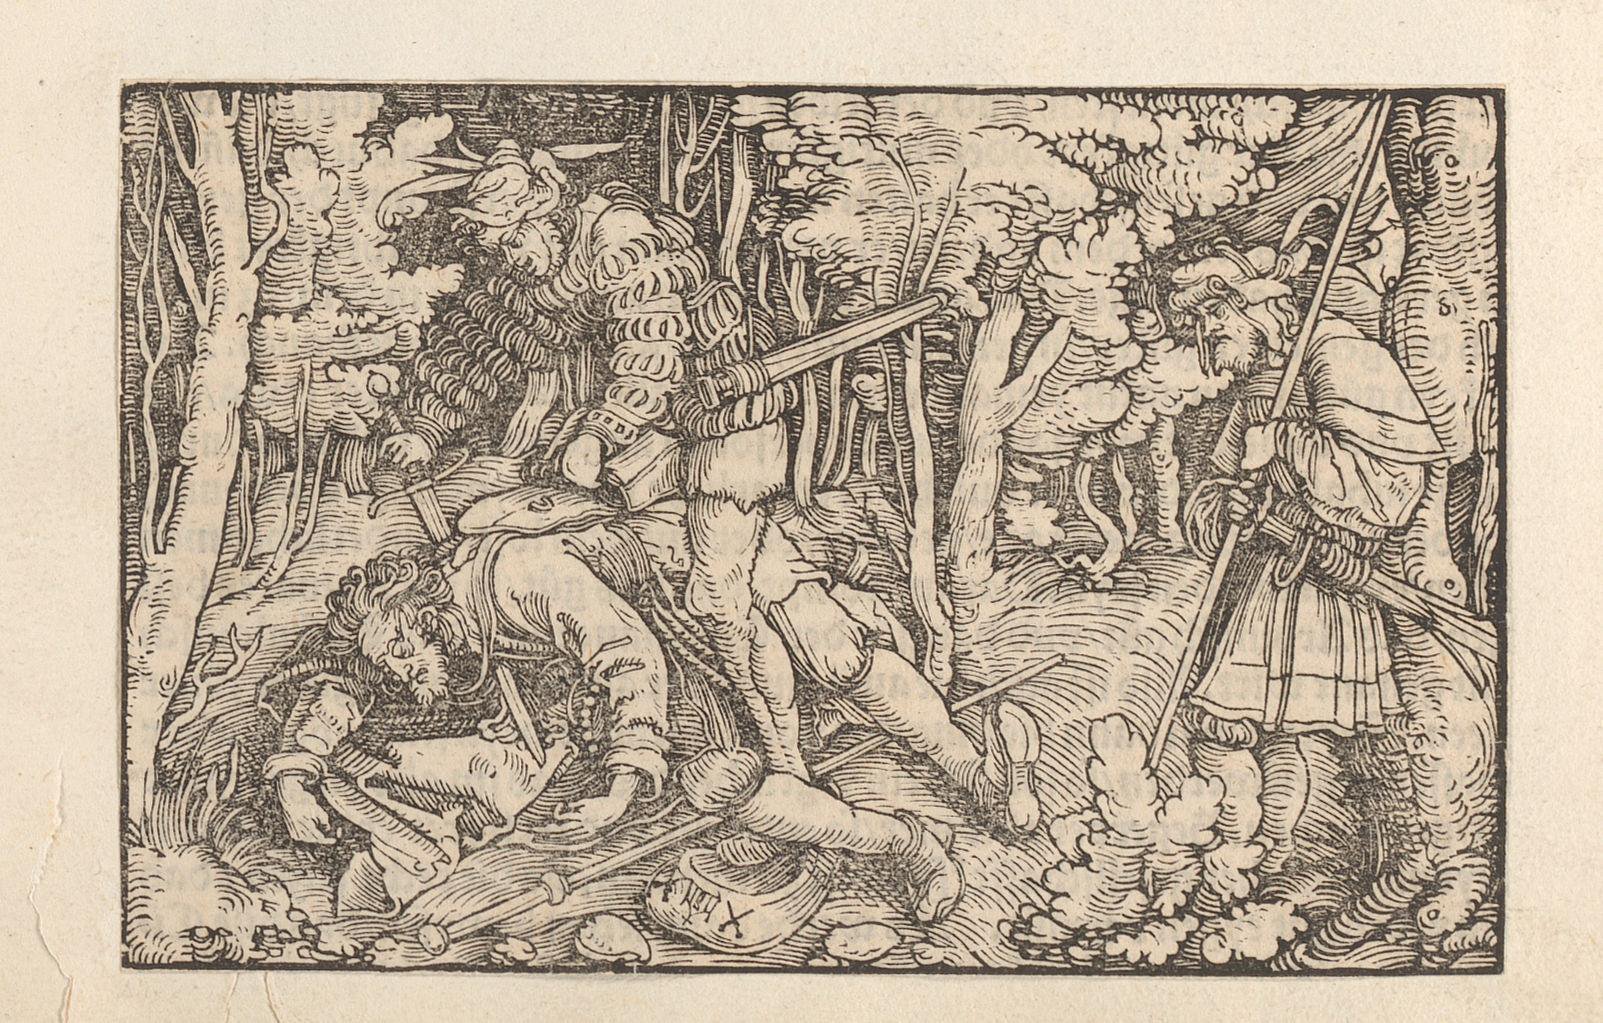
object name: book illustration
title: Landschap met moord op een pelgrim door twee gewapende mannen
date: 1514-1531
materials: paper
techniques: letterpress printing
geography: augsburg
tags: murder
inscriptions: collector's mark: Lugt 2165, collector's mark: Lugt 2166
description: Deze prent is gebruikt in: Cicero, Marcus Tulius. Officia M.T.C. Ein Buch so Marcus Tullius Cicero der Römer zu seynem (...). [Vertaald uit het Latijn door] Johann von Schwarzenberg. Augsburg: Heinrich Steiner, 1531.